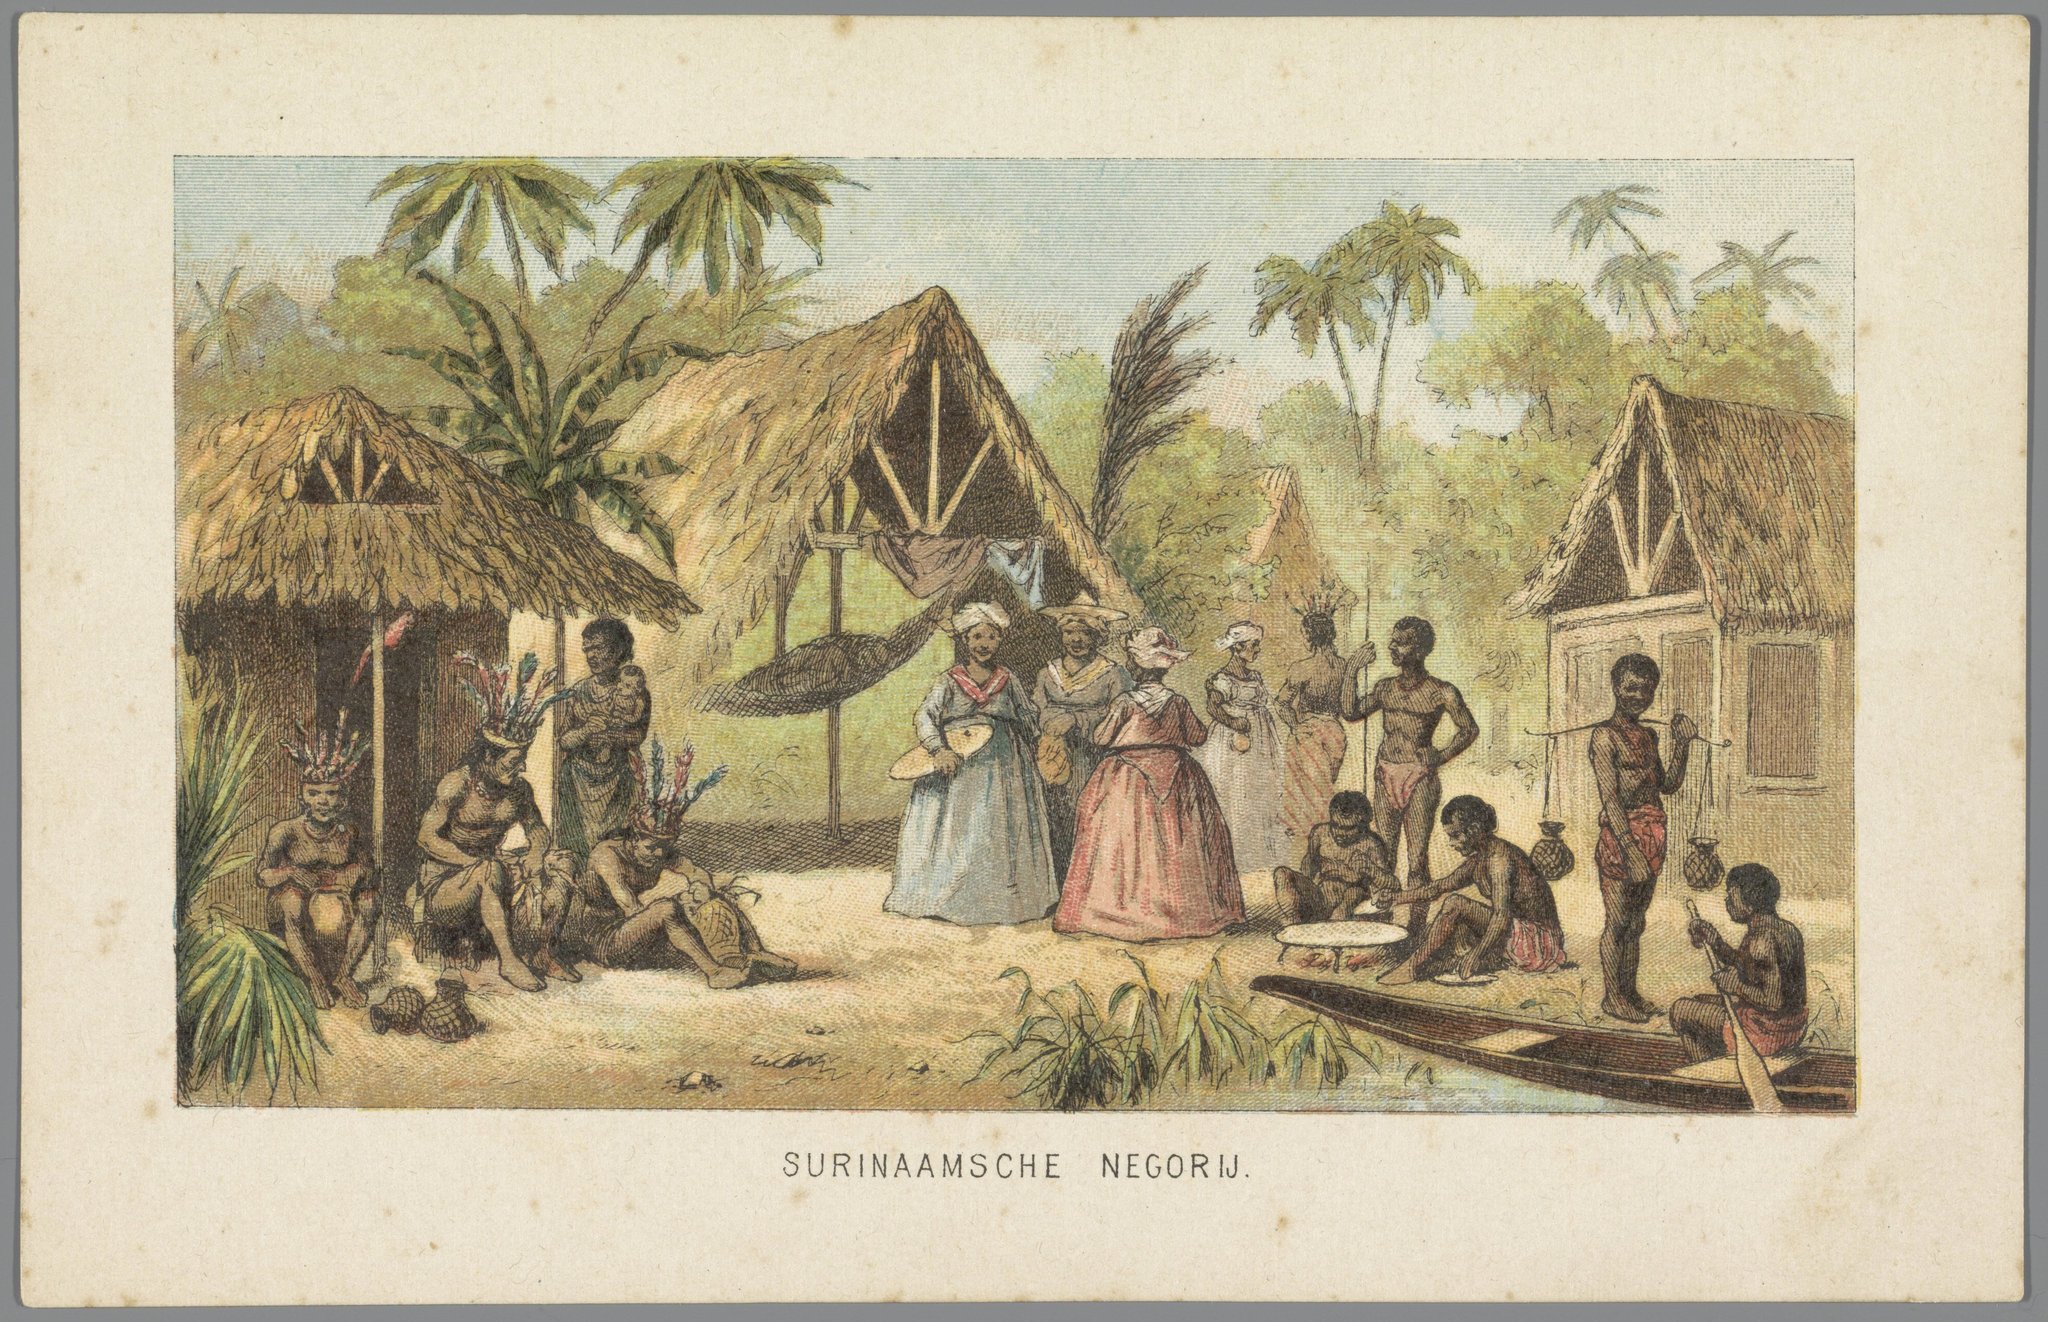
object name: print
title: Surinaamsche negorij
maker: Anonymous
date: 1883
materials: paper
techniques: chromolithography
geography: amsterdam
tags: world fair, world exhibition, suriname, amsterdam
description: Een Surinaamse dorp met inwoners tentoongesteld op de Wereldtentoonstelling op het Museumplein te Amsterdam. Onderdeel van een groep van zestien platen en een plattegrond van de Wereldtentoonstelling in Amsterdam van 1 mei tot 1 oktober 1883. Uitgave van het Nieuws van den Dag.